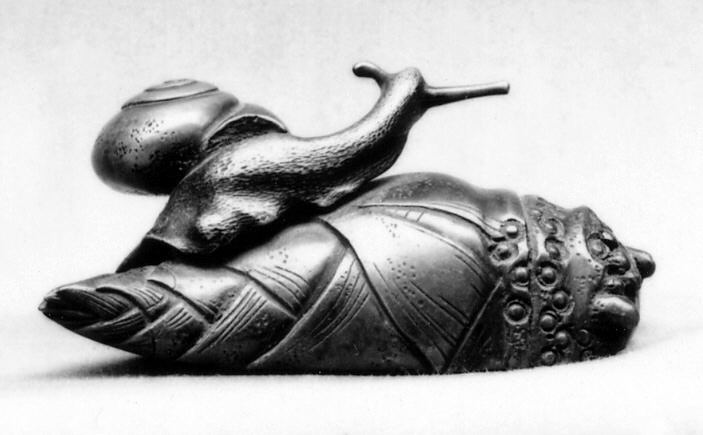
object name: ornament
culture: japanese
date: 1801-1900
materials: bronze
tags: snails